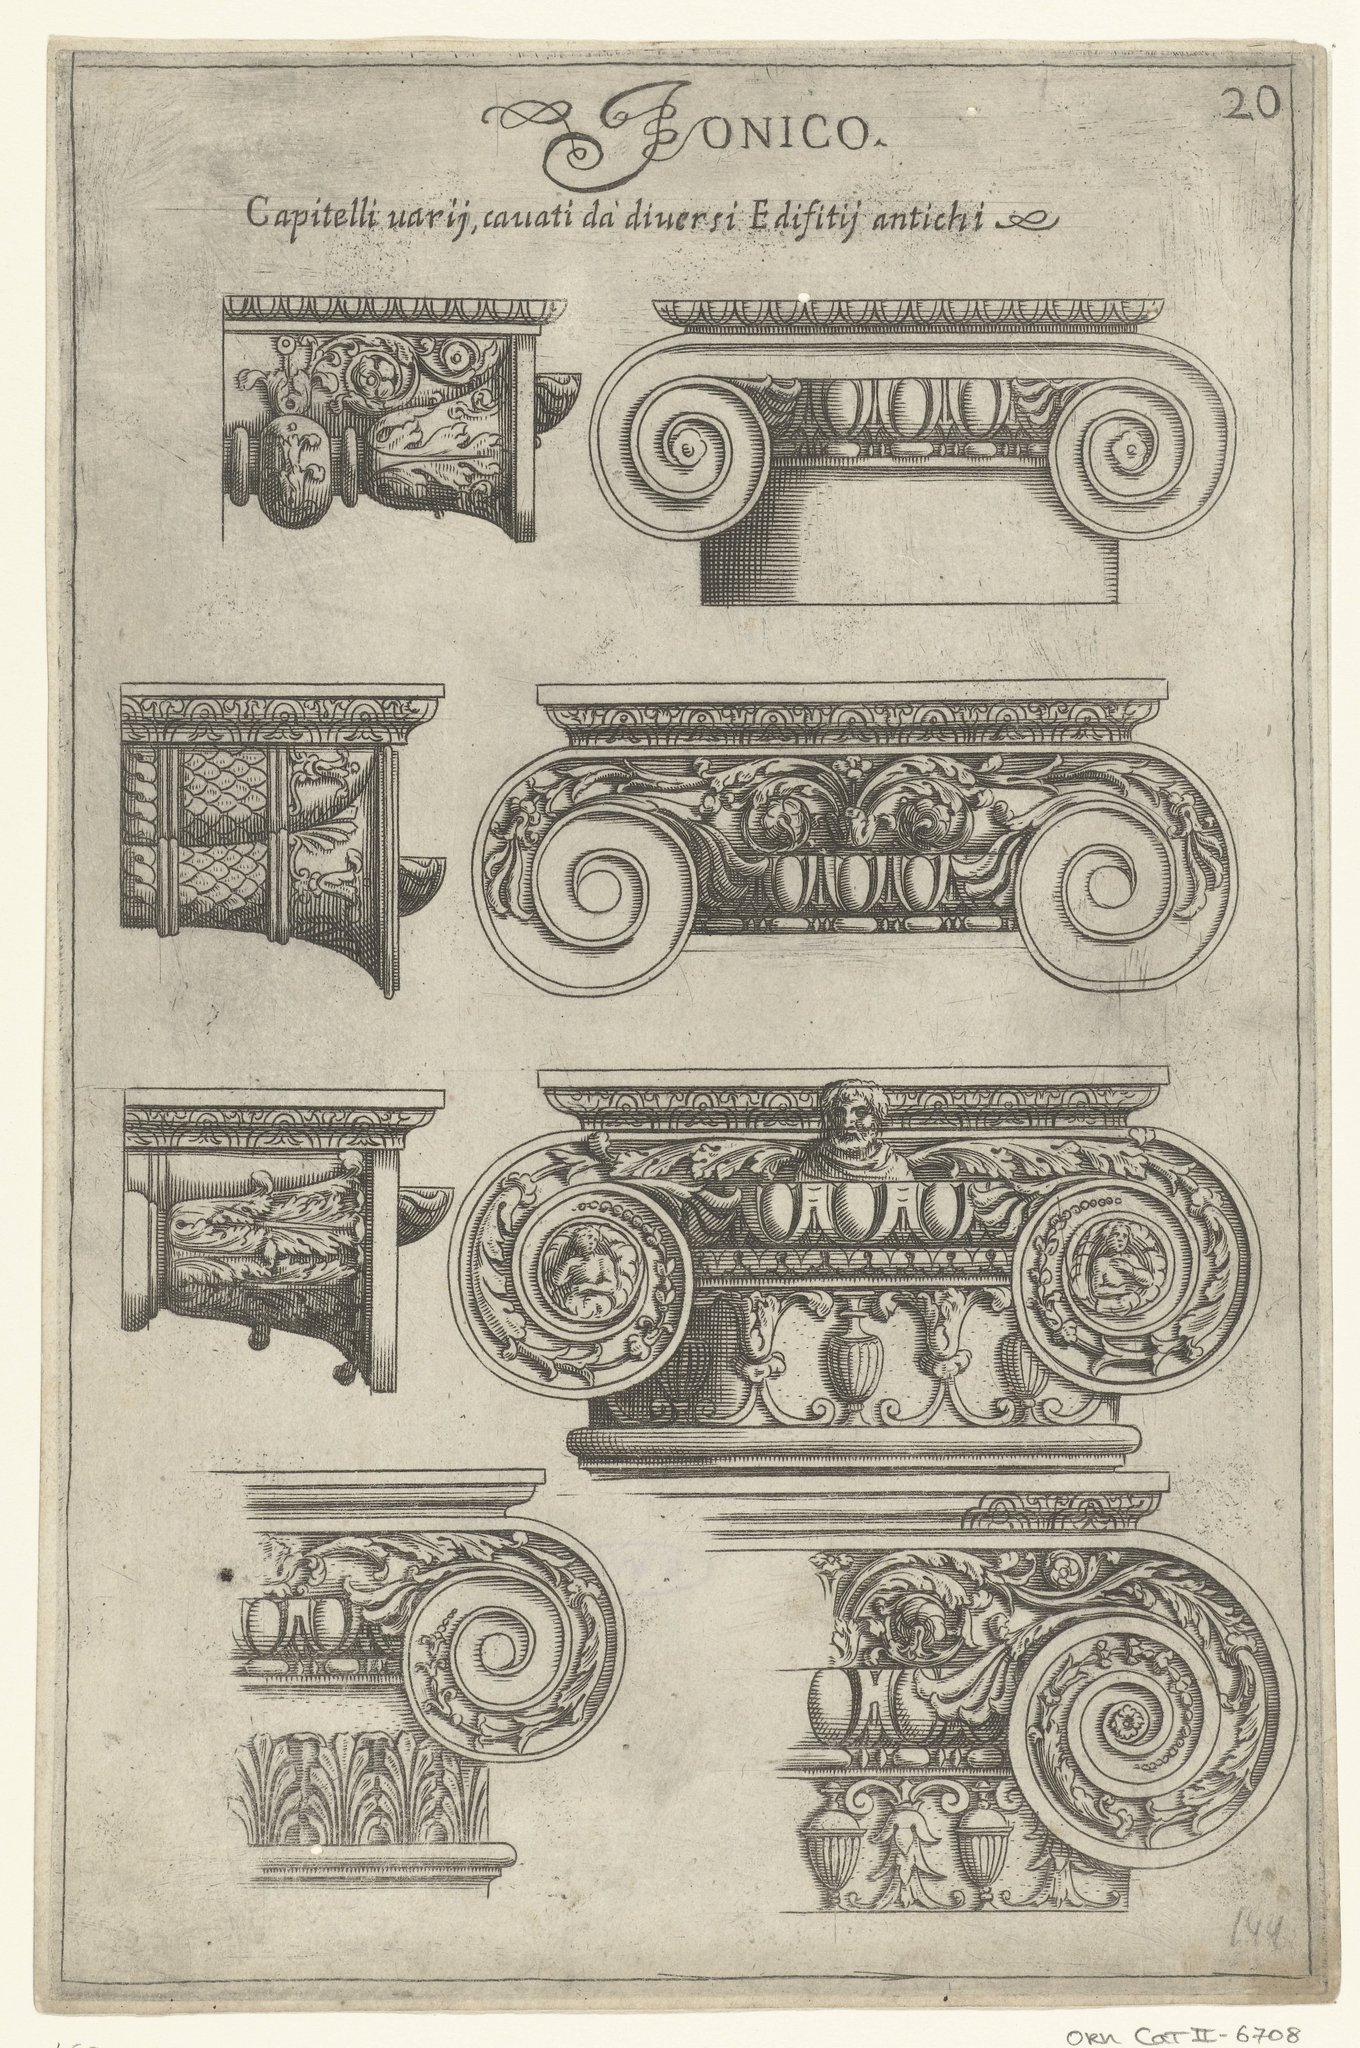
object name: print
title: Architettura con diversi ornamenti cavati dall' Antico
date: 1636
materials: paper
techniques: engraving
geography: italy